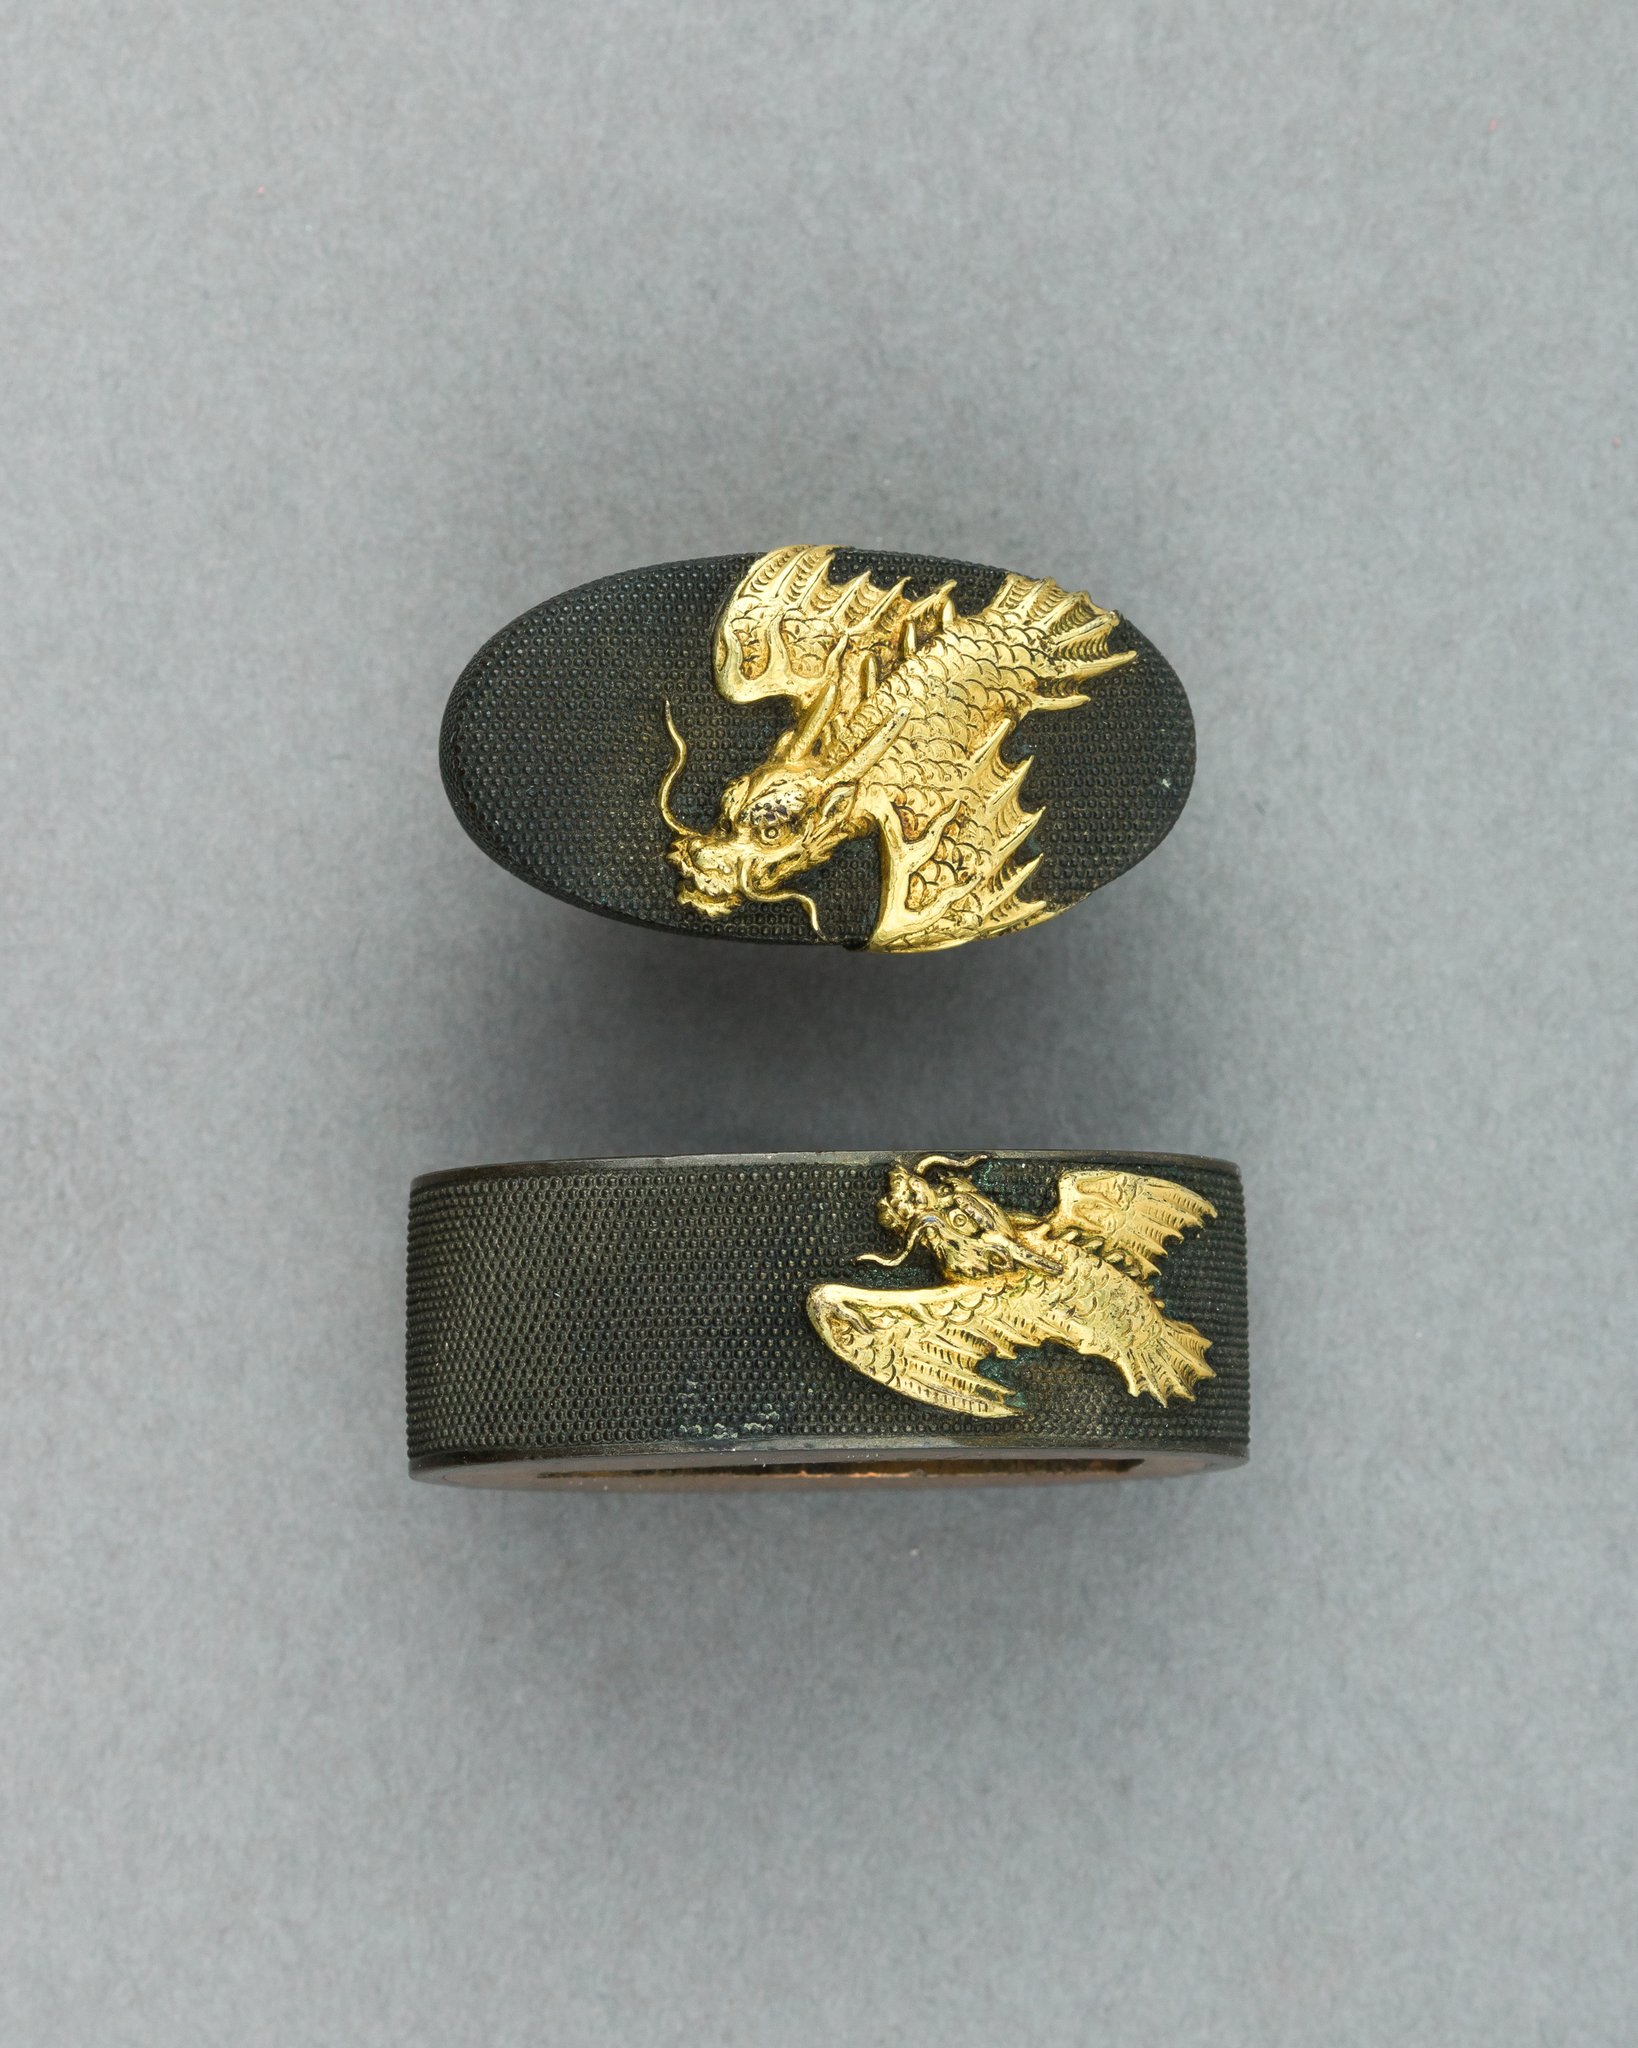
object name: sword hilt collar and pommel fuchigashira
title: Sword-Hilt Collar and Pommel (Fuchigashira)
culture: japanese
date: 1615-1868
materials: silver alloy, gold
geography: japan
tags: dragons